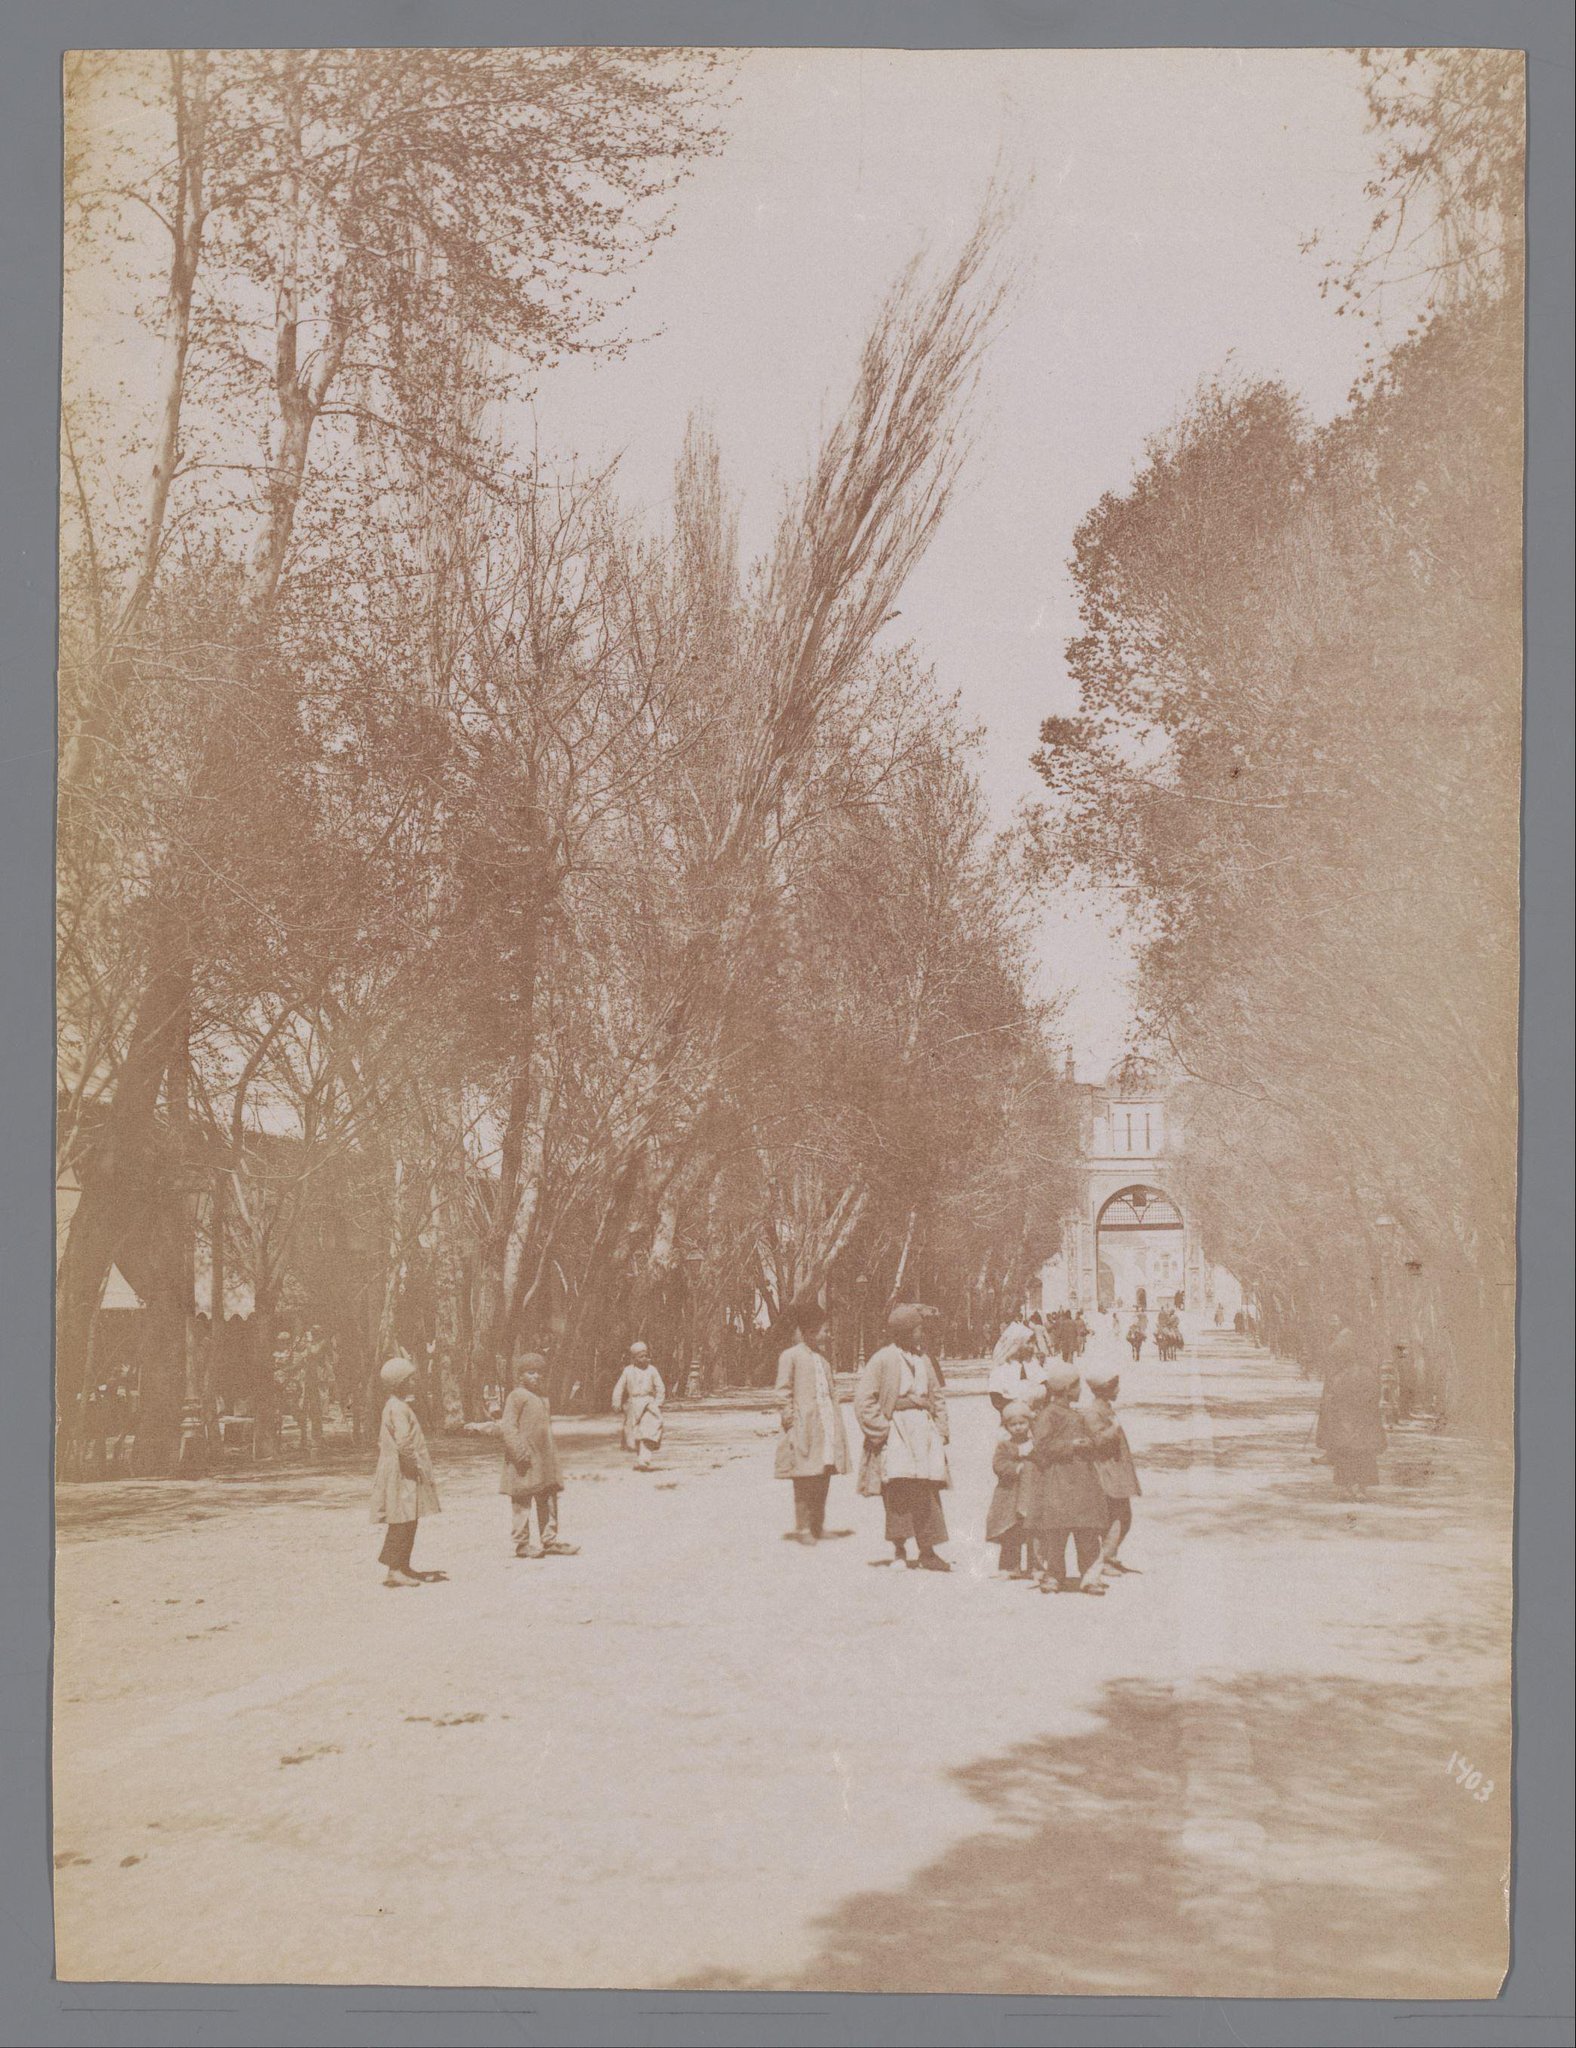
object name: photograph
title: "Avenue Almacheh [?]", Teheran, Iran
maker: antoine sevruguin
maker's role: fotograaf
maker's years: 1840-1933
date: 1880-1910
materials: paper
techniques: albumen print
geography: iran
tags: teheran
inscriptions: number: ‘17.’, inscription: ‘Teheran//Aveneu Almacheh [?]’, number: ‘1403’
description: Weg [in een park?] met bomen aan weerszijden, een groepje kinderen in het midden van de weg, op de achtergrond een boogvormige doorgang over de weg.